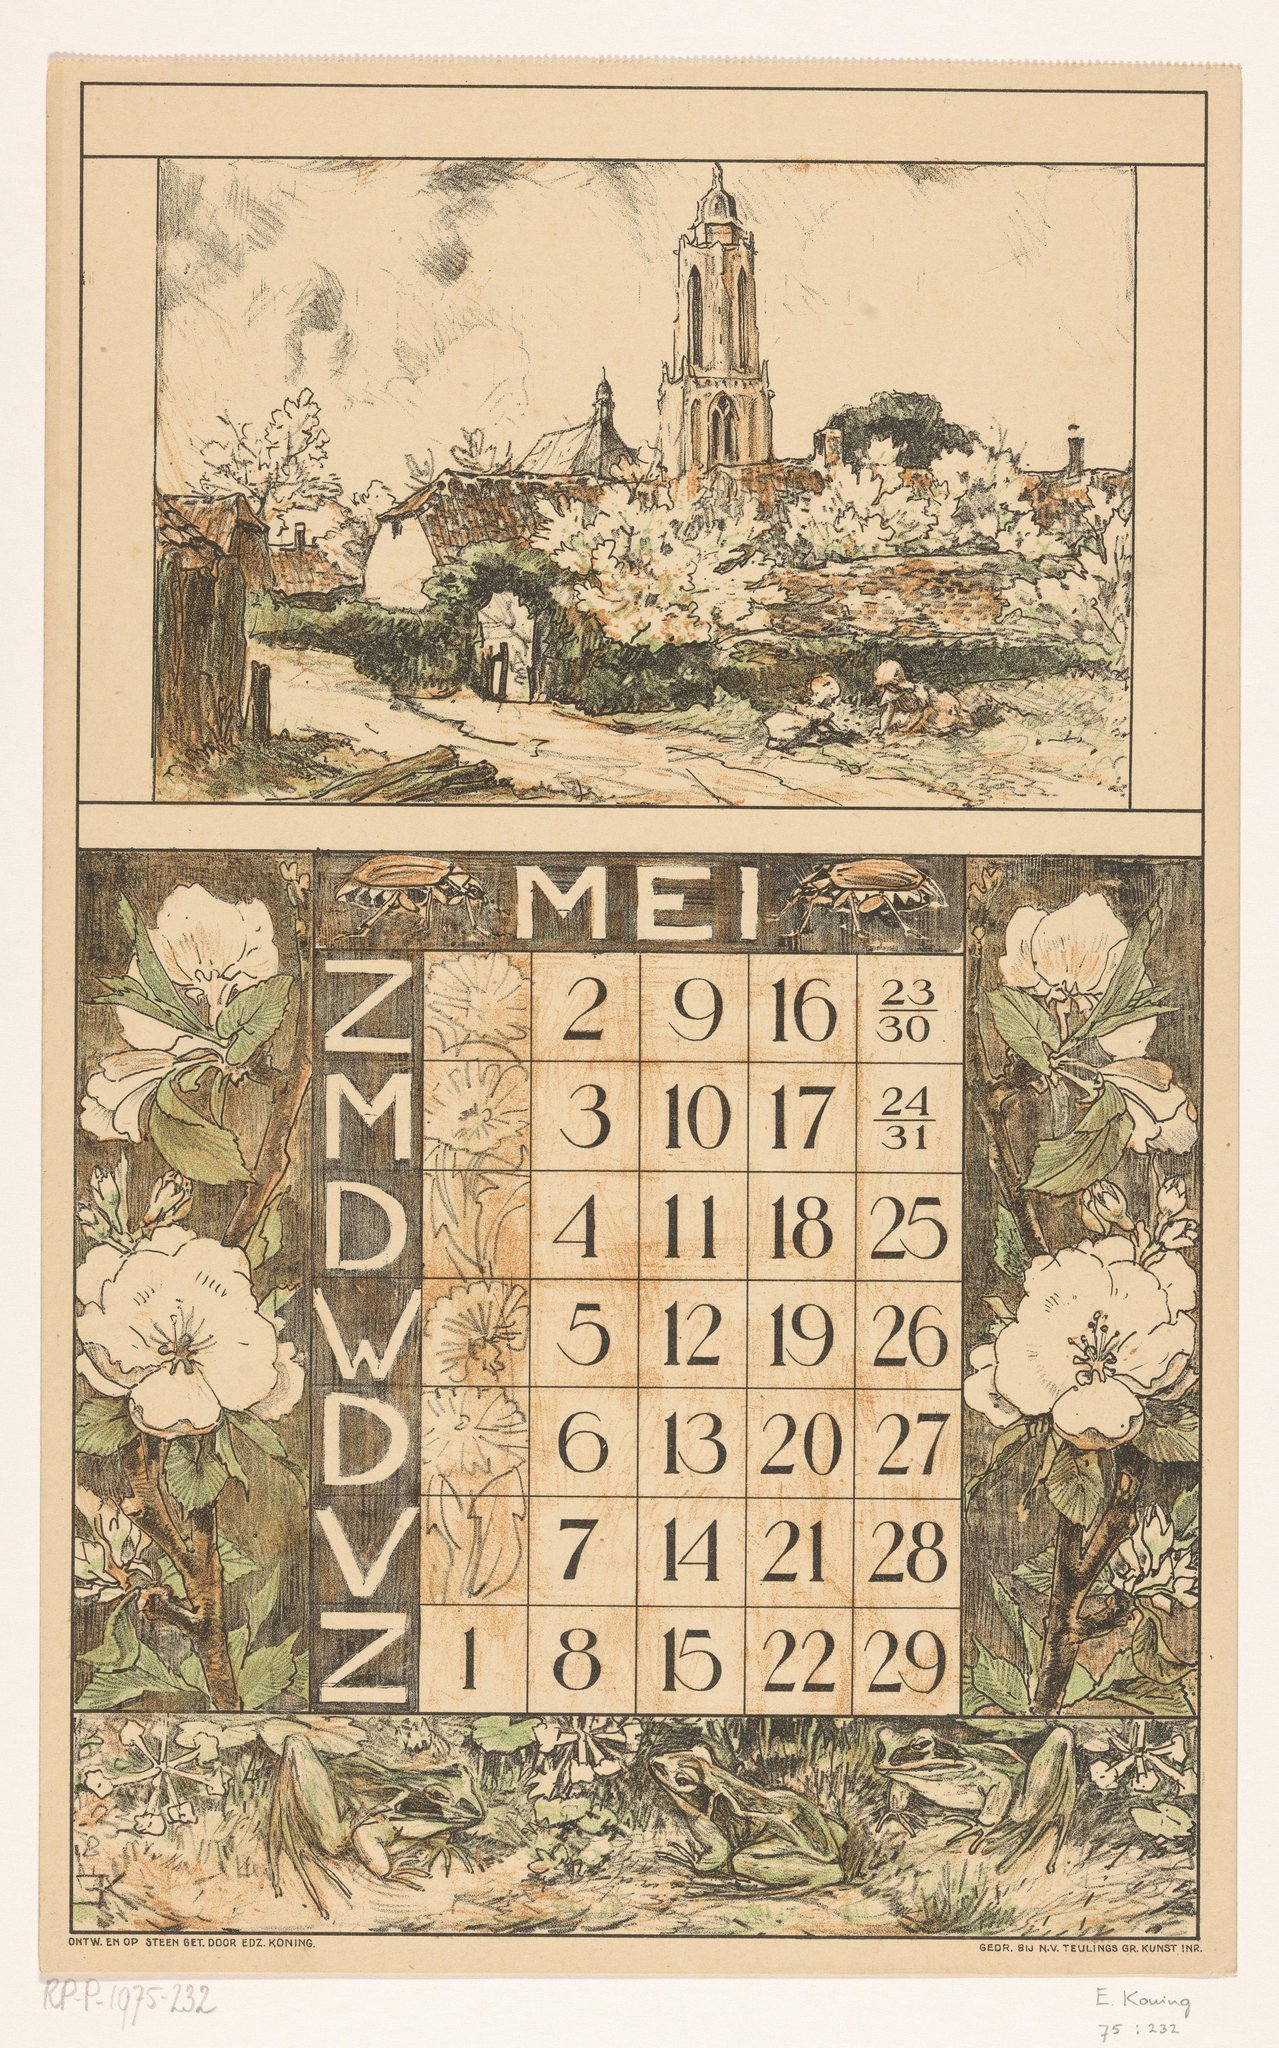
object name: print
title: Kalenderblad voor mei 1920 van de Nederlandsche Gist- en Spiritusfabriek in Delft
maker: edzard koning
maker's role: draughtsman, print maker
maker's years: 1869-1954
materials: paper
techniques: lithograph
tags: flowers, tailless amphibians: frog, parts of church exterior and annexes: tower, insects: beetle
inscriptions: collector's mark: Lugt 2228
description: Een vierkant kader opgevuld met de dagen van de maand mei en daaromheen appelbloesem, drie kikkers en twee kevers. Bovenaan een rechthoekig kader met daarin een stadsgezicht met kerk.